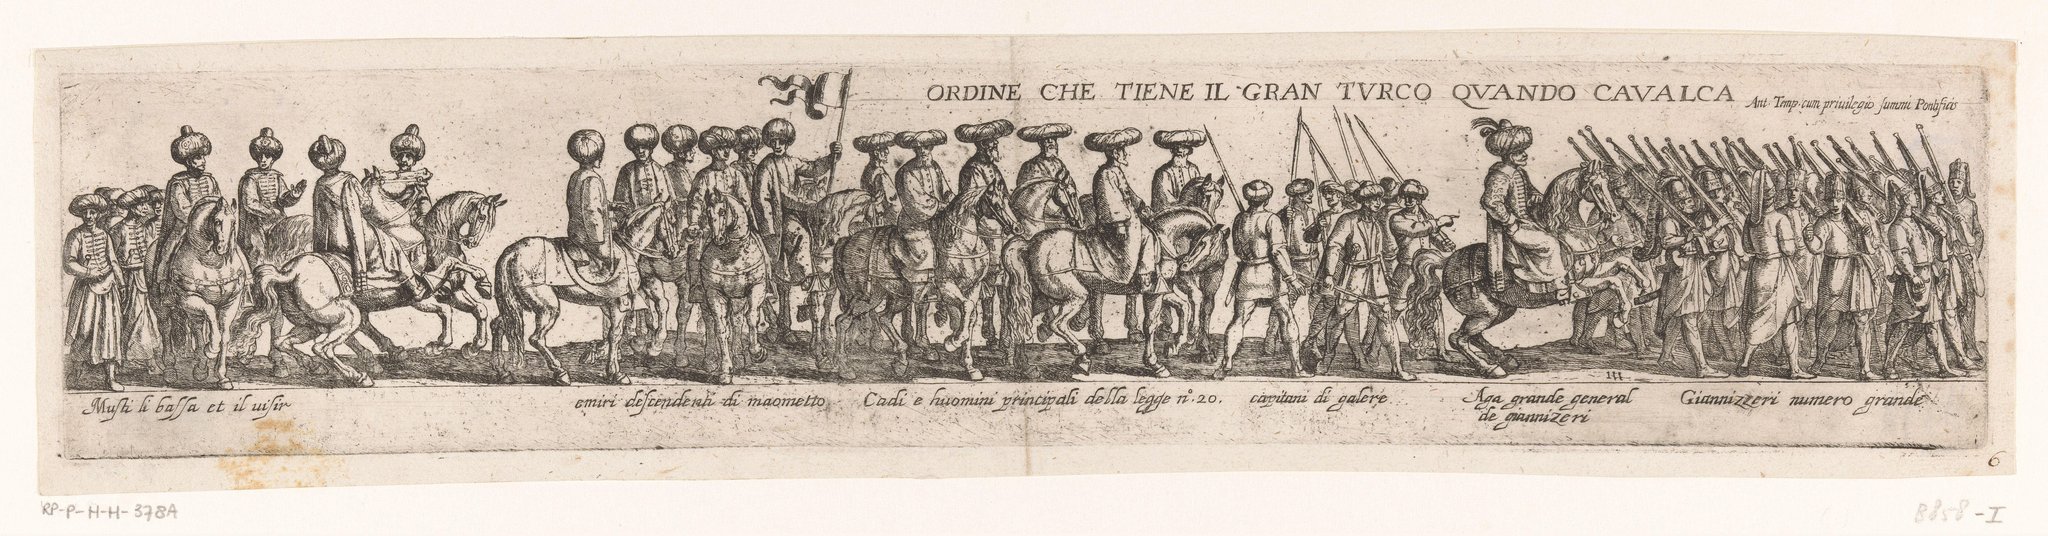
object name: print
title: Ordine che tiene il gran Turco quando cavalca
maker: antonio tempesta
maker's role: draughtsman, painter, print maker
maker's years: 1555-1630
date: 1565-1630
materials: paper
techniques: etching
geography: italy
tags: ceremonial procession, parade, pageant ~ installation of a ruler, festivities (+ the public ~ festive activities), head-gear: turban, warfare; military affairs (+ cavalry, horsemen)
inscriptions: number: ‘6’, collector's mark: ‘Hinloopen’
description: Deel van een parade met soldaten te paard en voetsoldaten, vanwege het vertrek van een sultan. Bijschriften in het Italiaans in ondermarge.